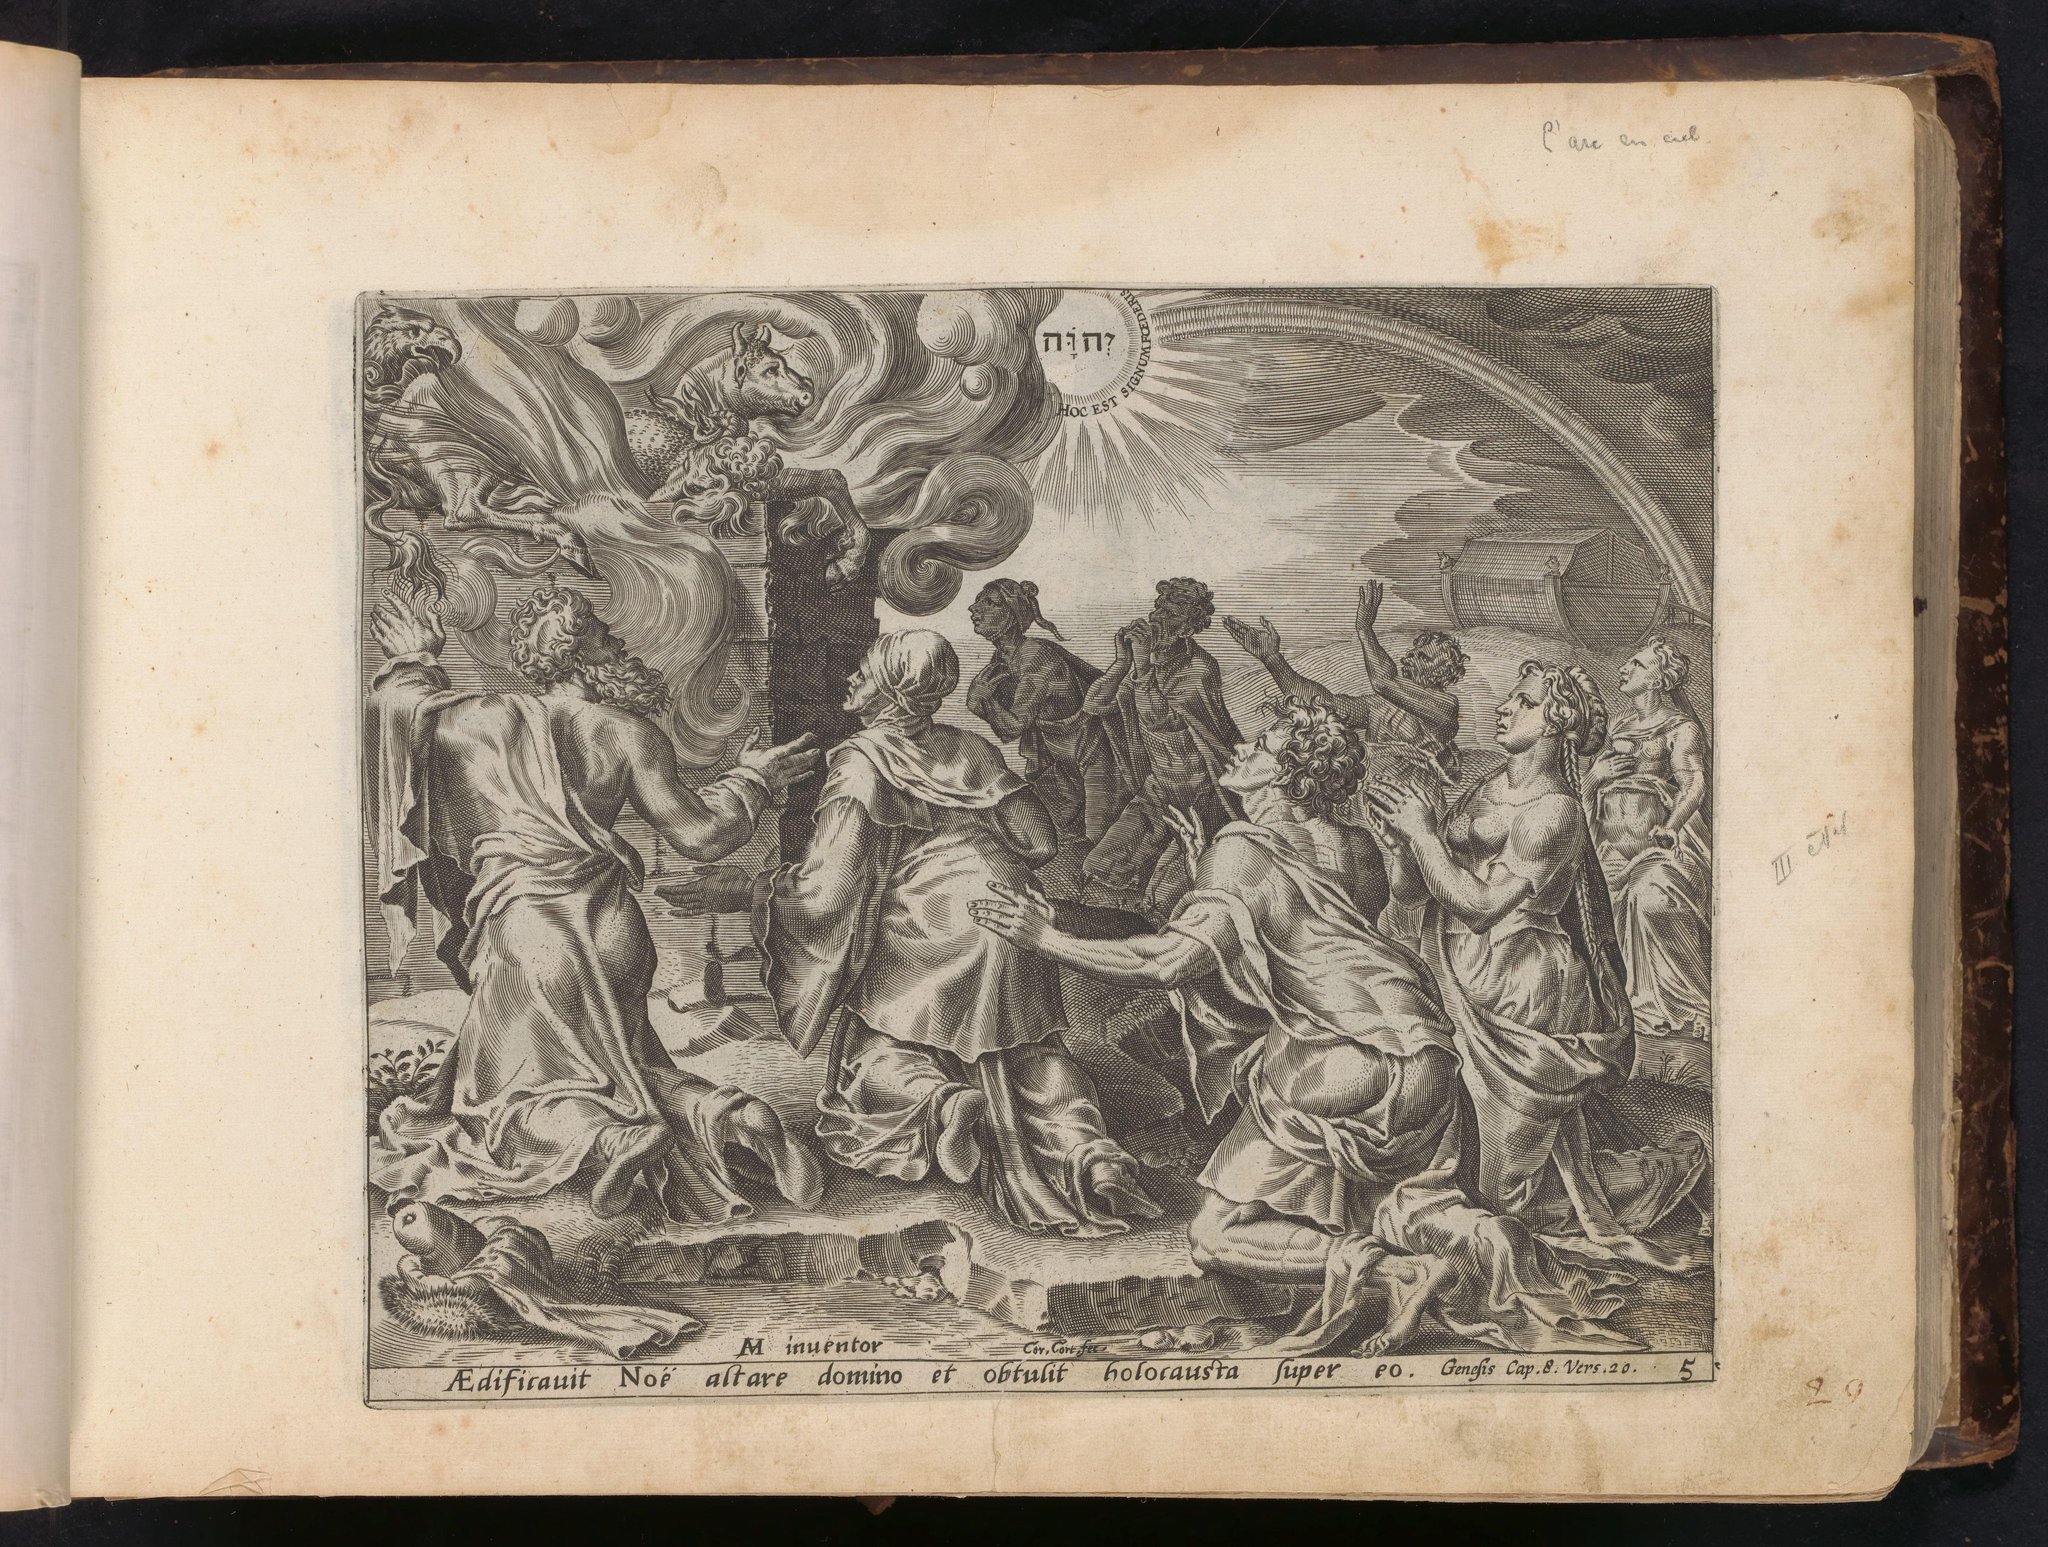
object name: print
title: Van Noah en de Diluvie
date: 1558-1560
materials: paper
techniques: engraving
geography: amsterdam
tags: god's covenant with noah: never again shall there be a flood; as a sign of this covenant god puts a rainbow in the sky, noah's sacrifice; various animals are offered, possibly a lamb, a dove and a ram (often combined with the rainbow of the covenant)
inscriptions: number: ‘29’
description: Links een altaar waarop verschillende dieren orden geofferd. Noach en zijn familie knielen rond het altaar. In de lucht het symbool voor God, het tetragram, en de regenboog ten teken van Gods verbond. Rechtsachter staat op een heuvel de ark. Onderaan een verwijzing naar de Bijbeltekst in Gen. 8:20 in het Latijn. Deze prent maakt deel uit van een album.